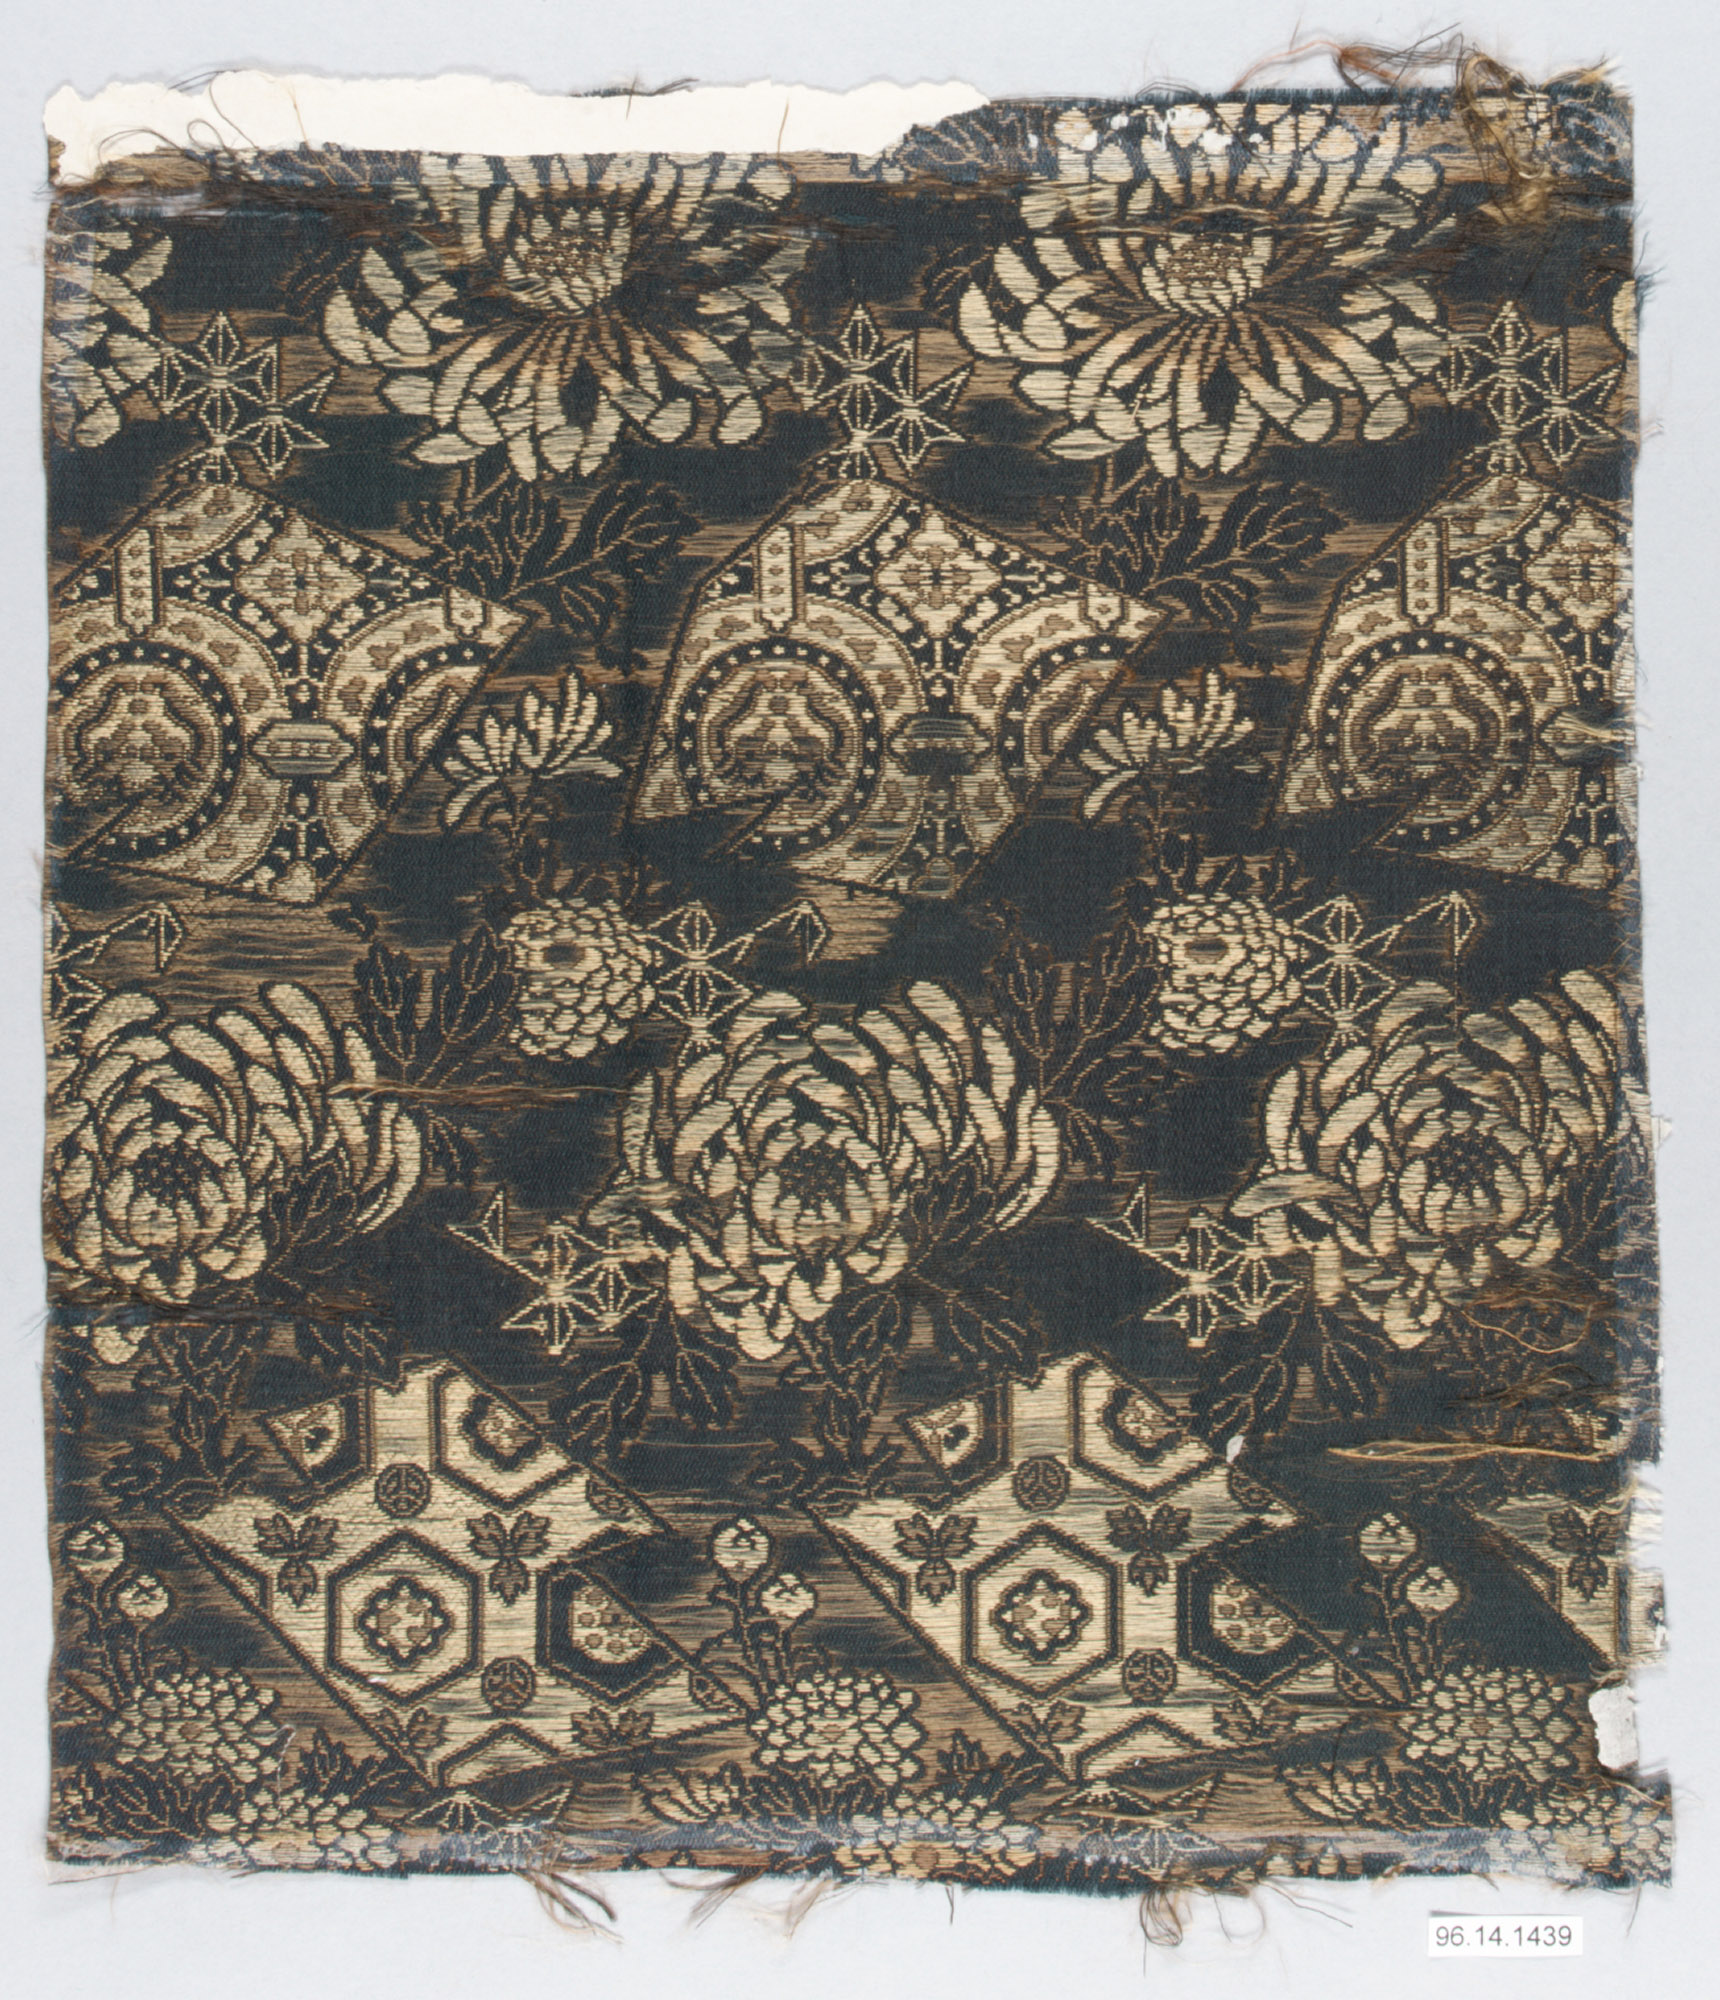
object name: piece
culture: japanese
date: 1801-1900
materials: silk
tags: leaves